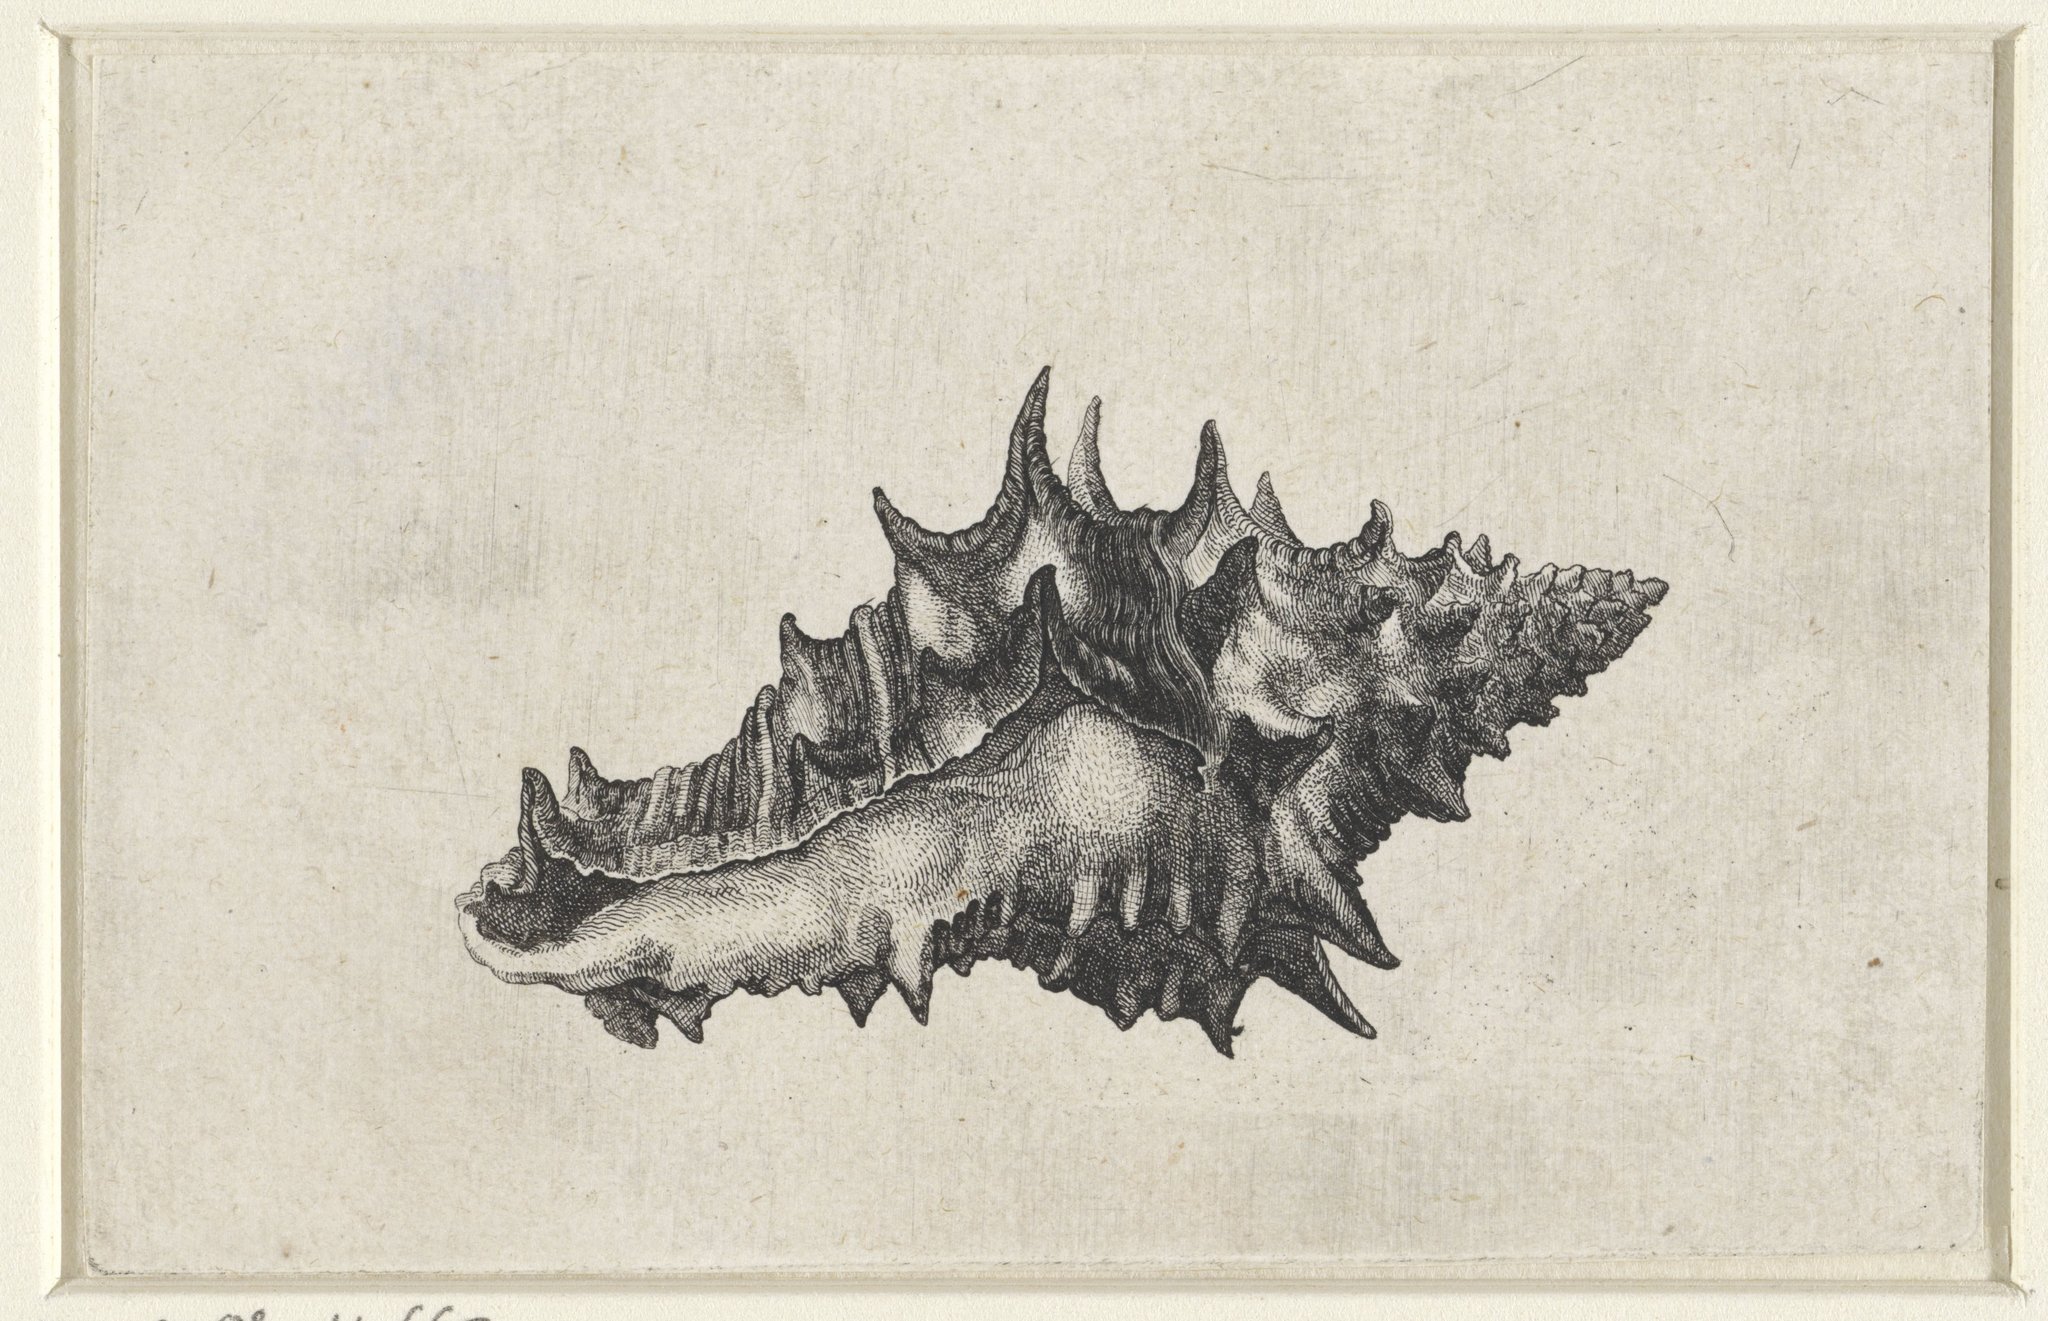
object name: print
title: Schelpen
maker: wenceslaus hollar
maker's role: draughtsman, print maker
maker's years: 1607-1677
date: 1644-1652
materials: paper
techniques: etching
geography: antwerp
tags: molluscs (+ shell, snail-shell etc.)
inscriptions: collector's mark: Lugt 240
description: Prent maakt deel uit van een 39-delige serie met verschillende soorten schelpen.